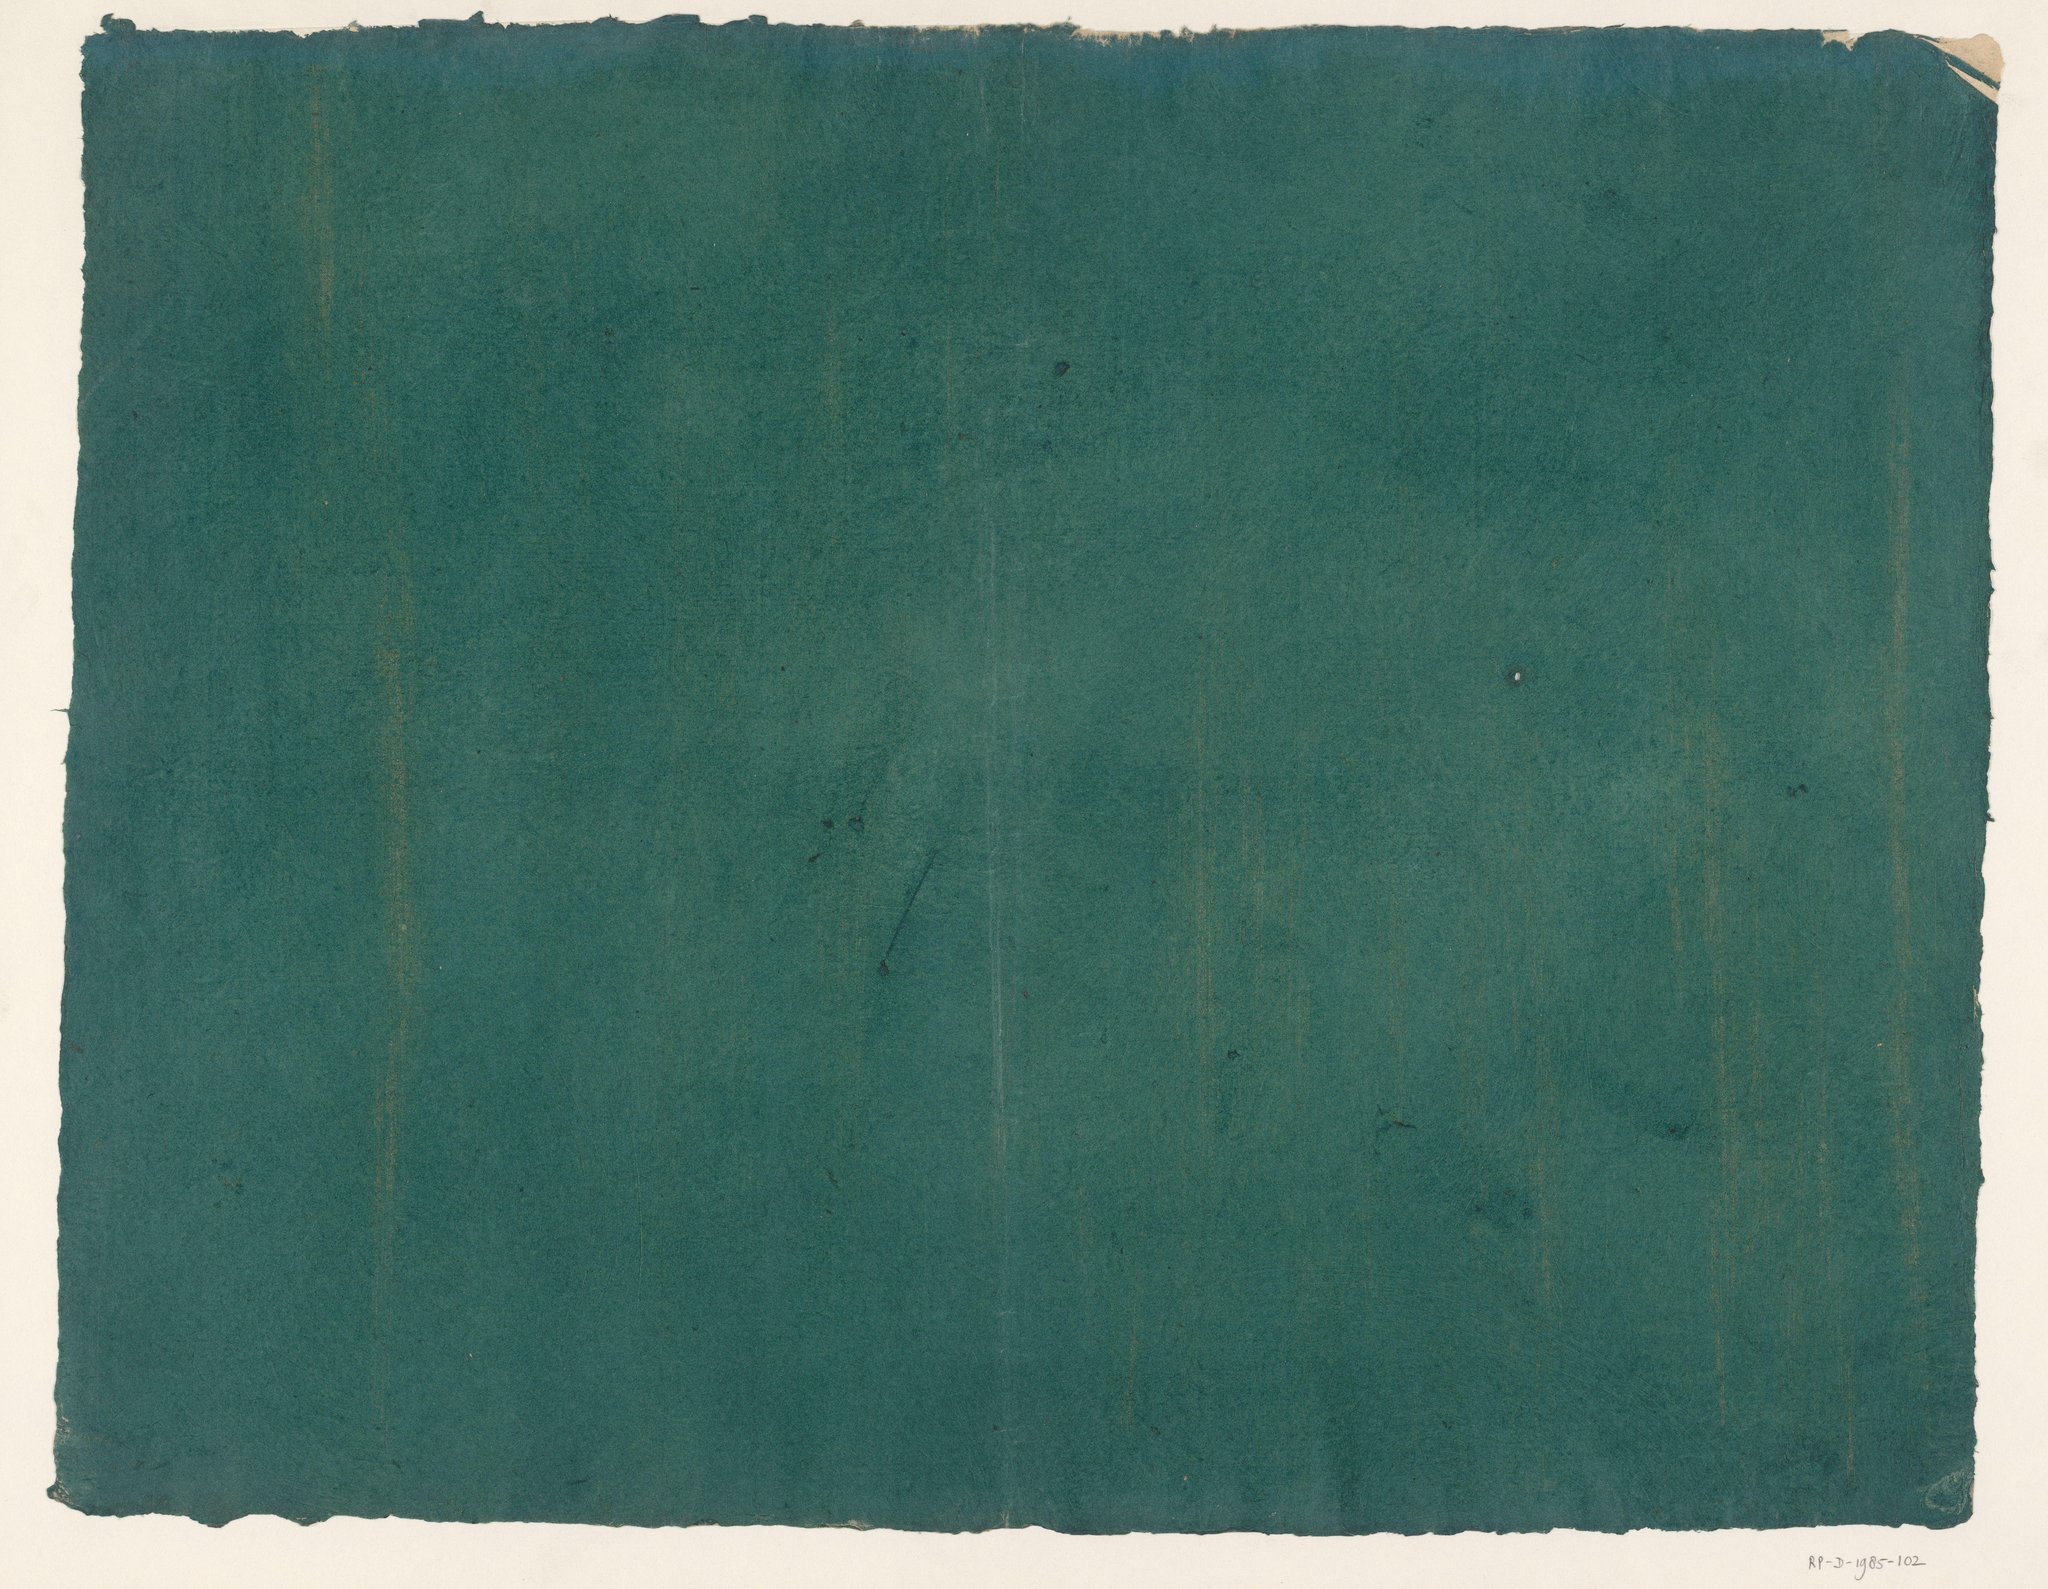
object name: decorated paper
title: Blad effen gestreken in groen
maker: Anonymous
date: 1800-1900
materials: paper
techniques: painting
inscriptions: collector's mark: Lugt 2228, collector's mark: Lugt 2760